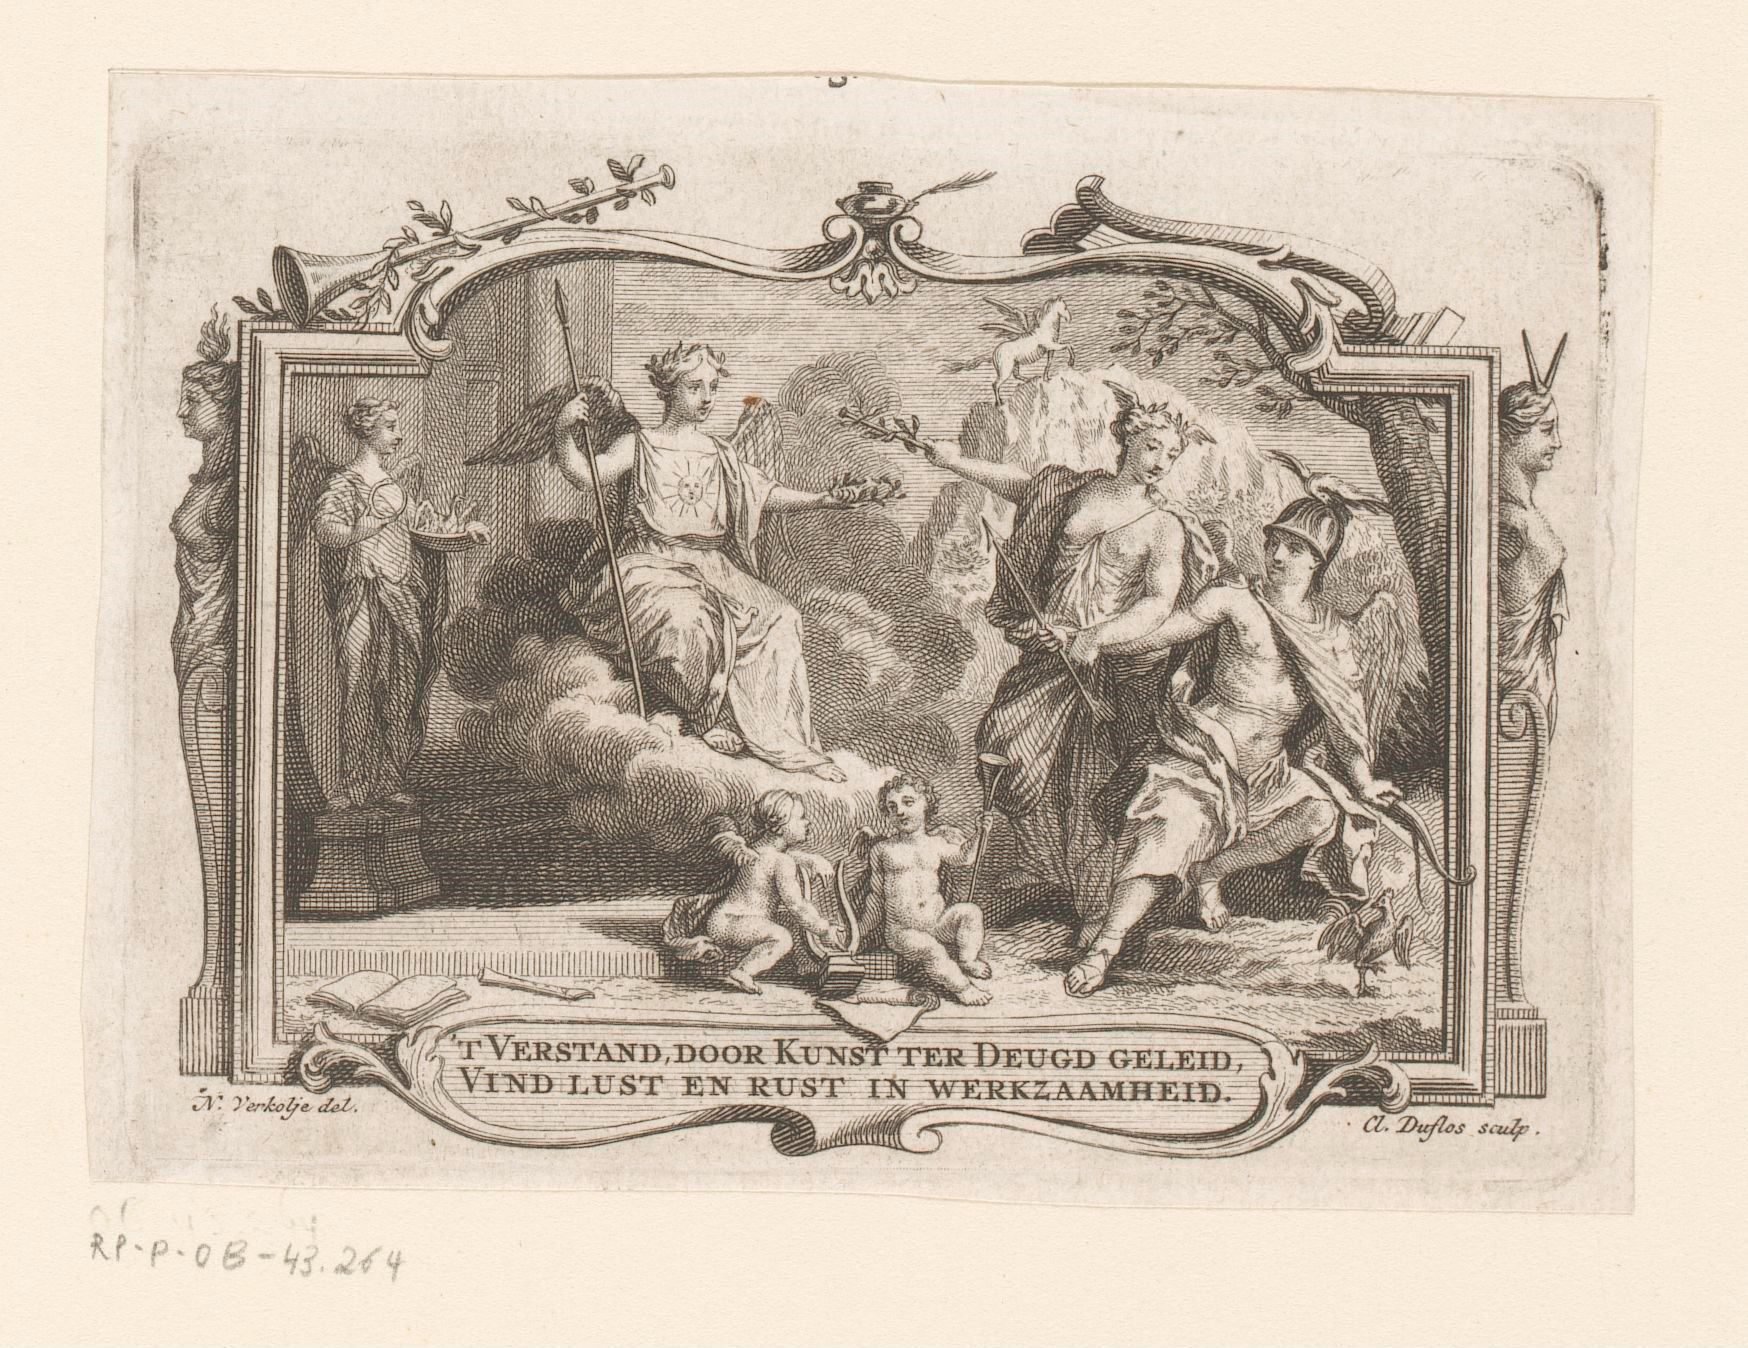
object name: titelblad, titelpagina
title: Allegorische voorstelling met Pegasus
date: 1735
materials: paper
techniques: engraving, etching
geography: amsterdam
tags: pegasus, the winged horse, intellect, intelligence; 'intelletto', 'intelligenza' (ripa), symbolic representations, allegories and emblems ~ art; 'arte' (ripa)